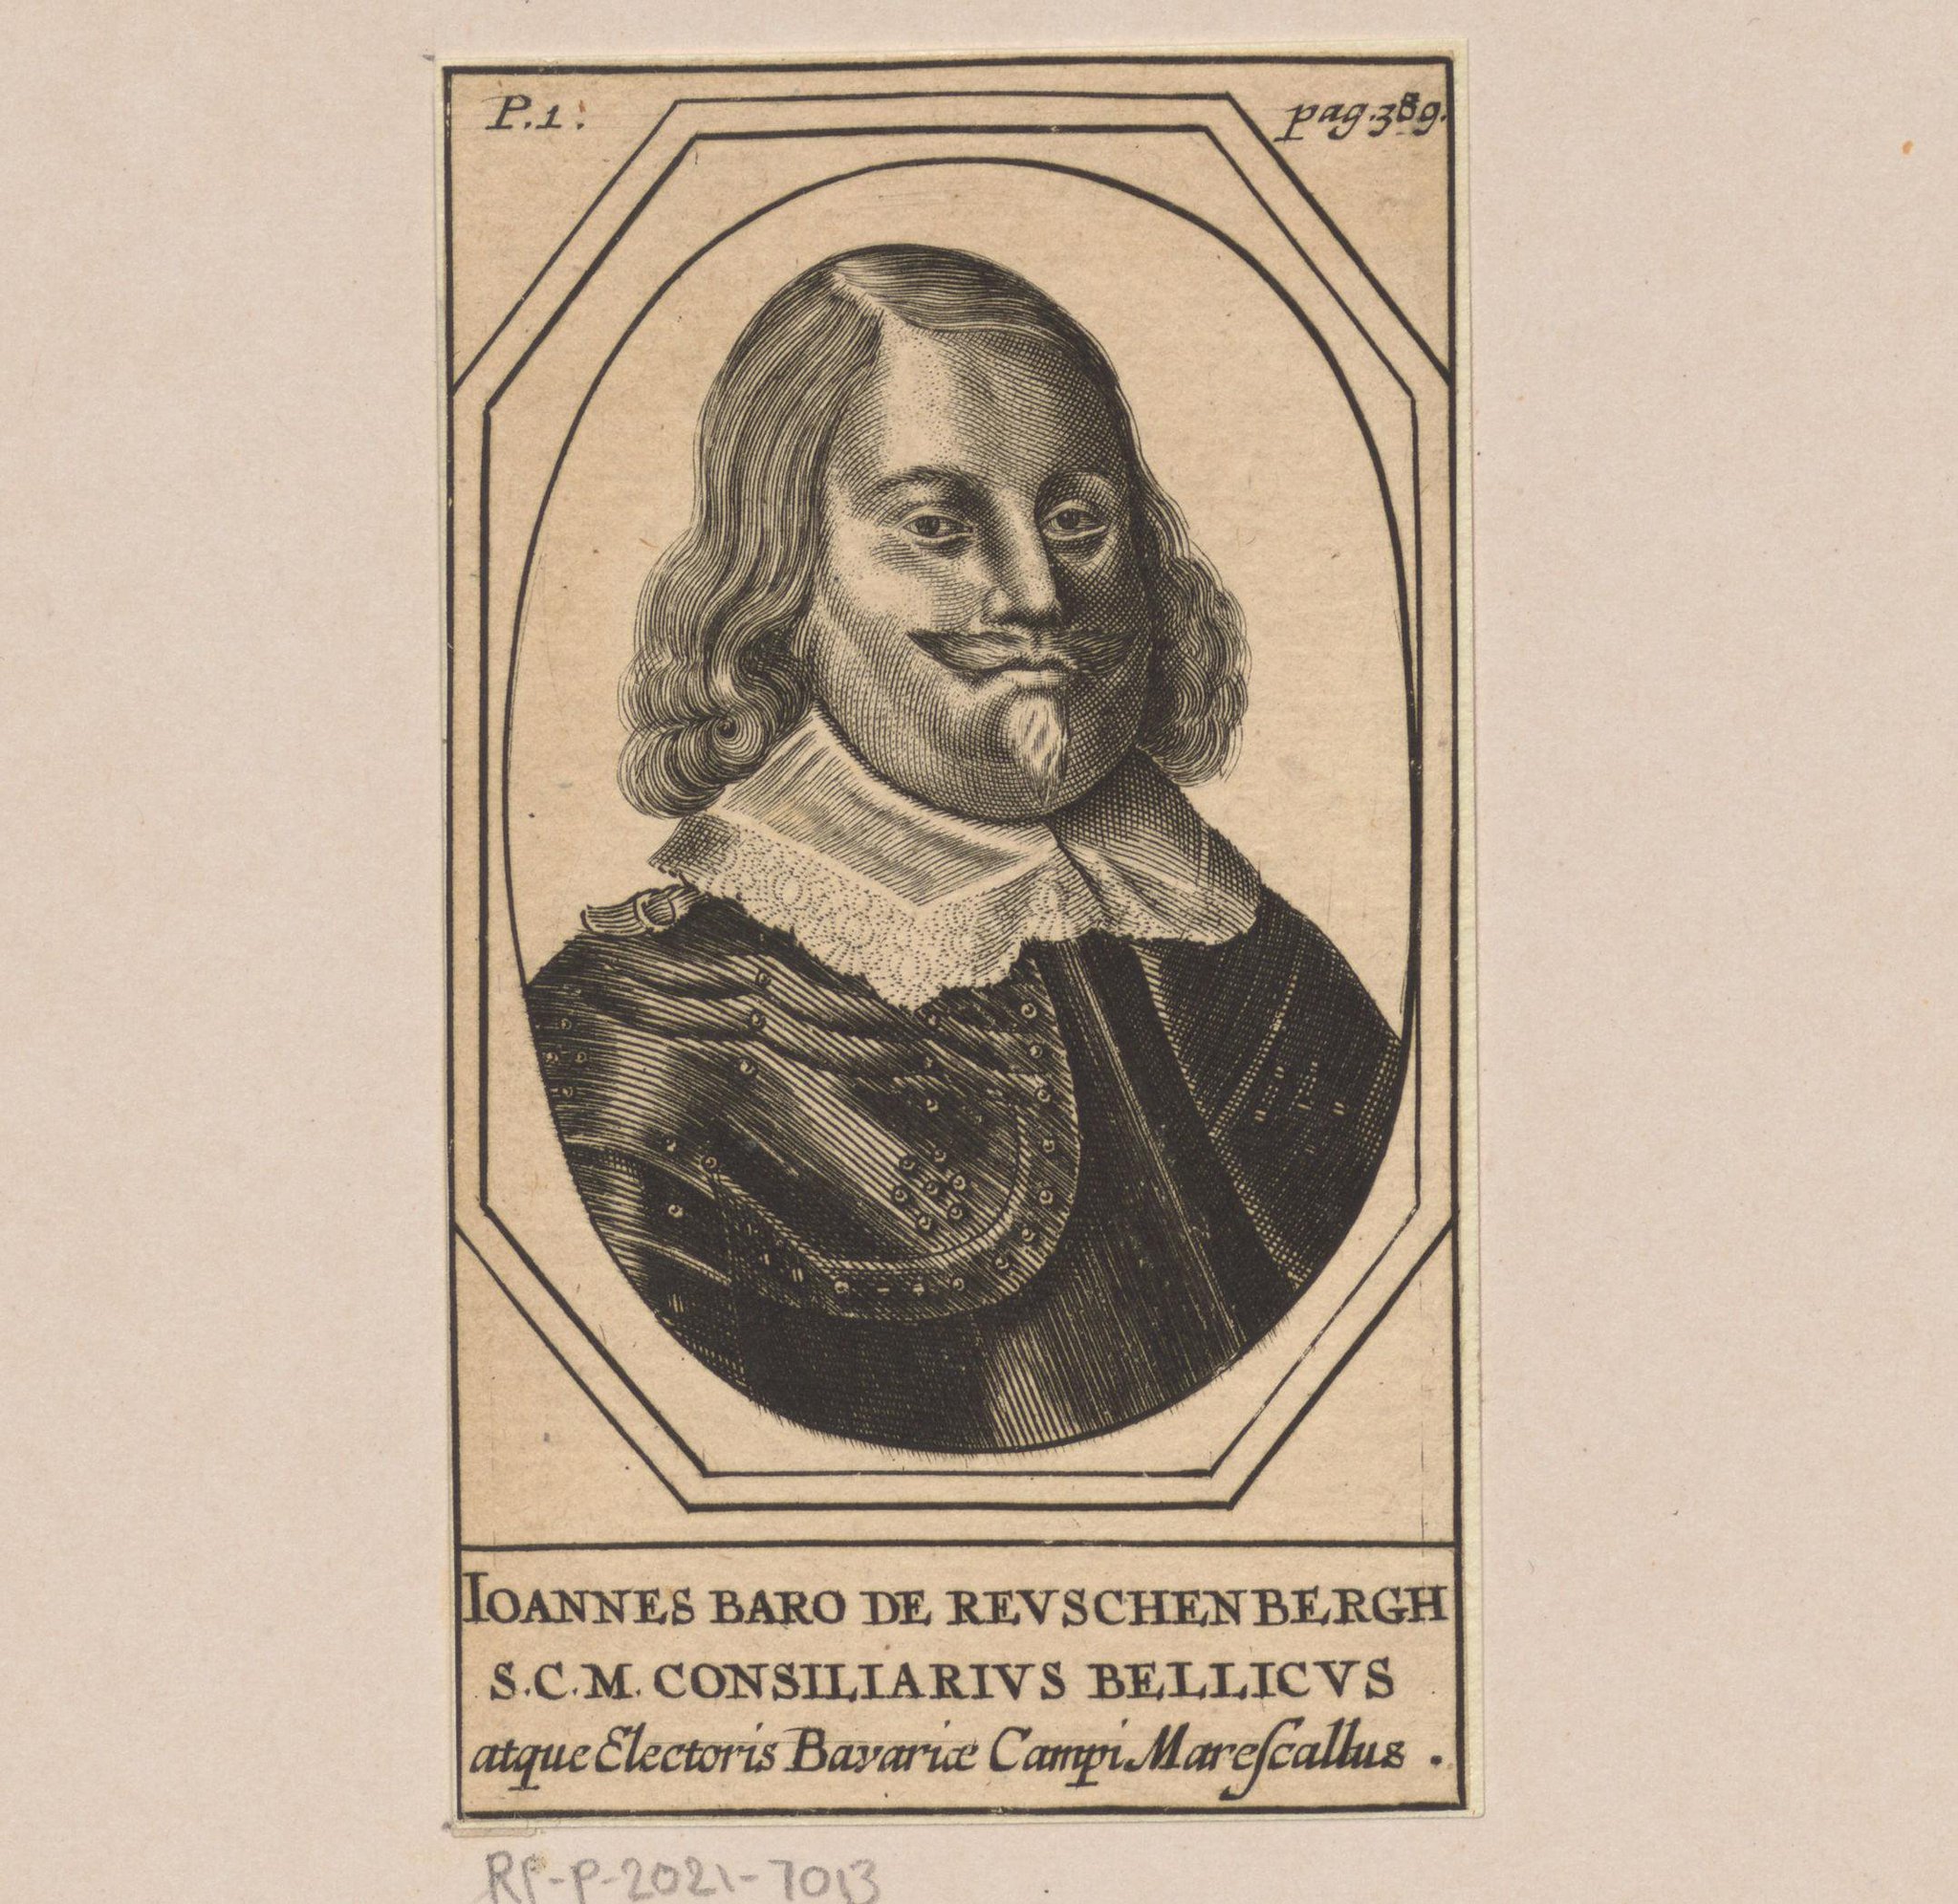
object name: print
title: Portret van Johann von Reuschenberg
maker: Anonymous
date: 1655-1659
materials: paper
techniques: engraving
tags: cologne, historical persons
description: Prent mogelijk uit: Brachelius, Adolphus. Historiarum nostri temporis. Amsterdam: Jacob van Meurs, 1655. Of uit een latere editie (1659).